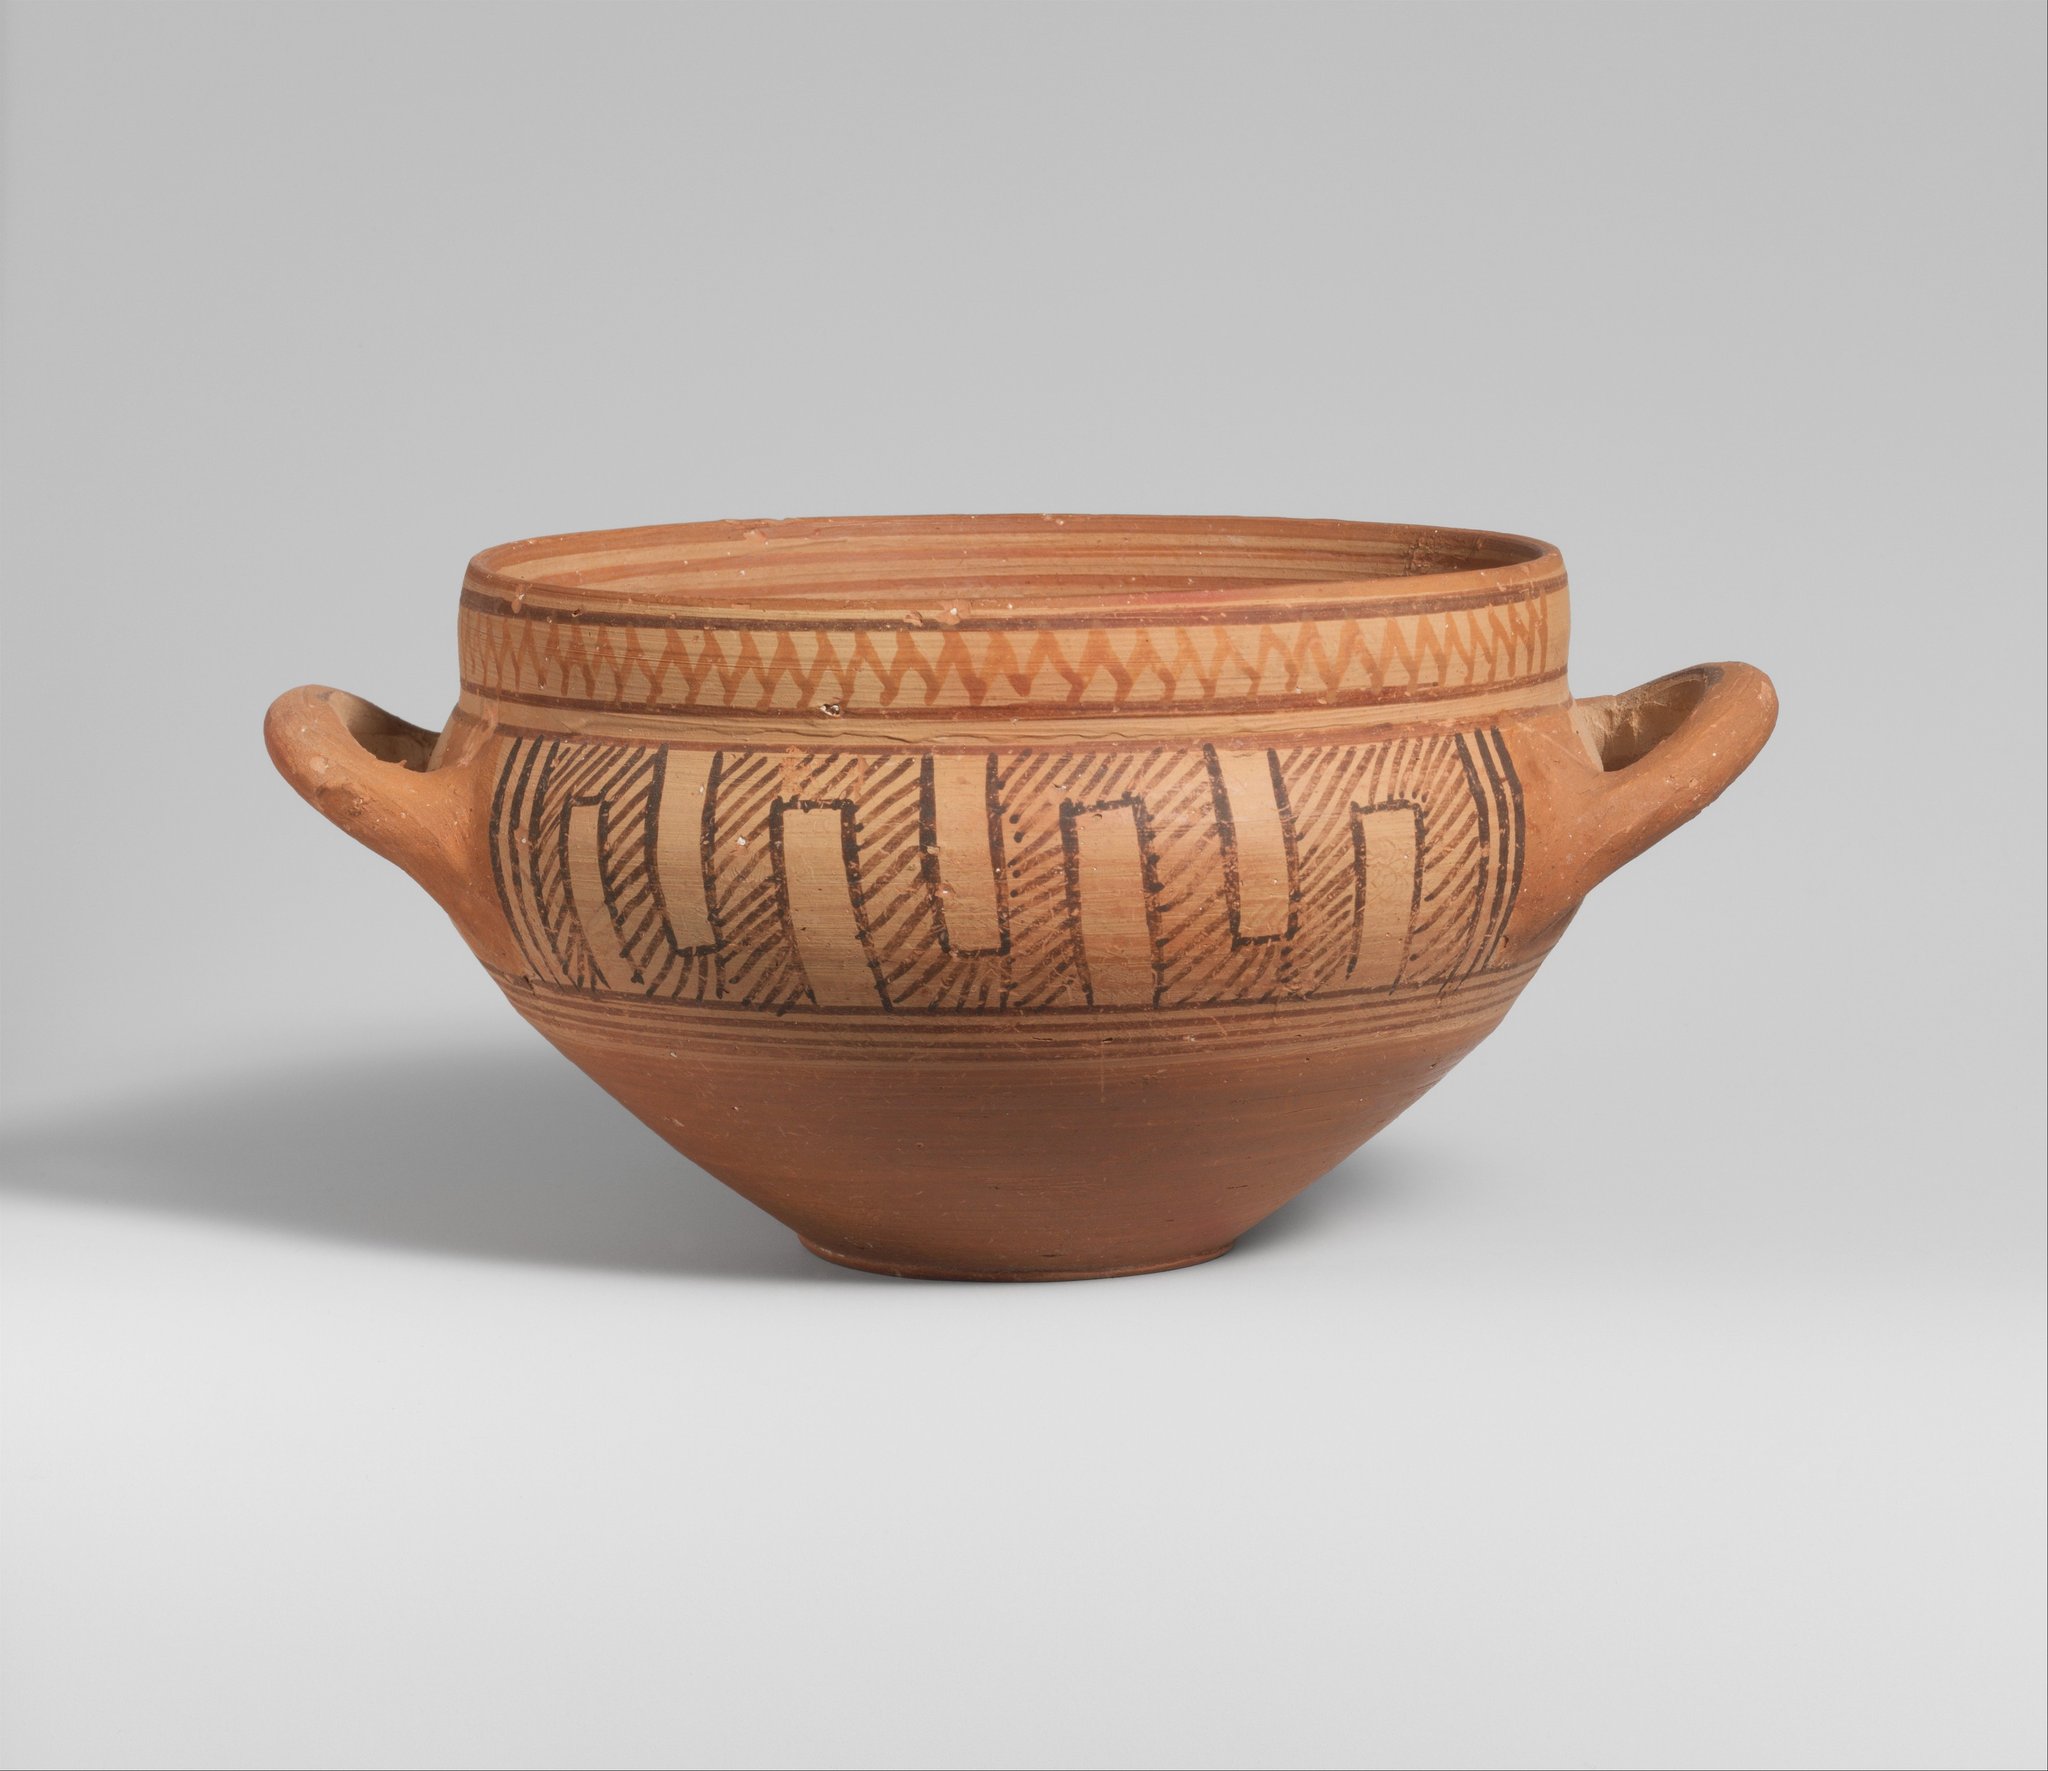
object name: skyphos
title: Terracotta skyphos (deep drinking cup)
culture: cypriot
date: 800-751 BCE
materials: terracotta